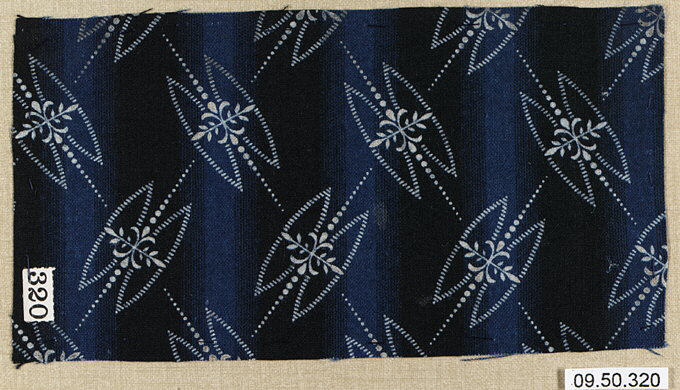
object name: piece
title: Piece (one of 116)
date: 1801-1900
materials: cotton